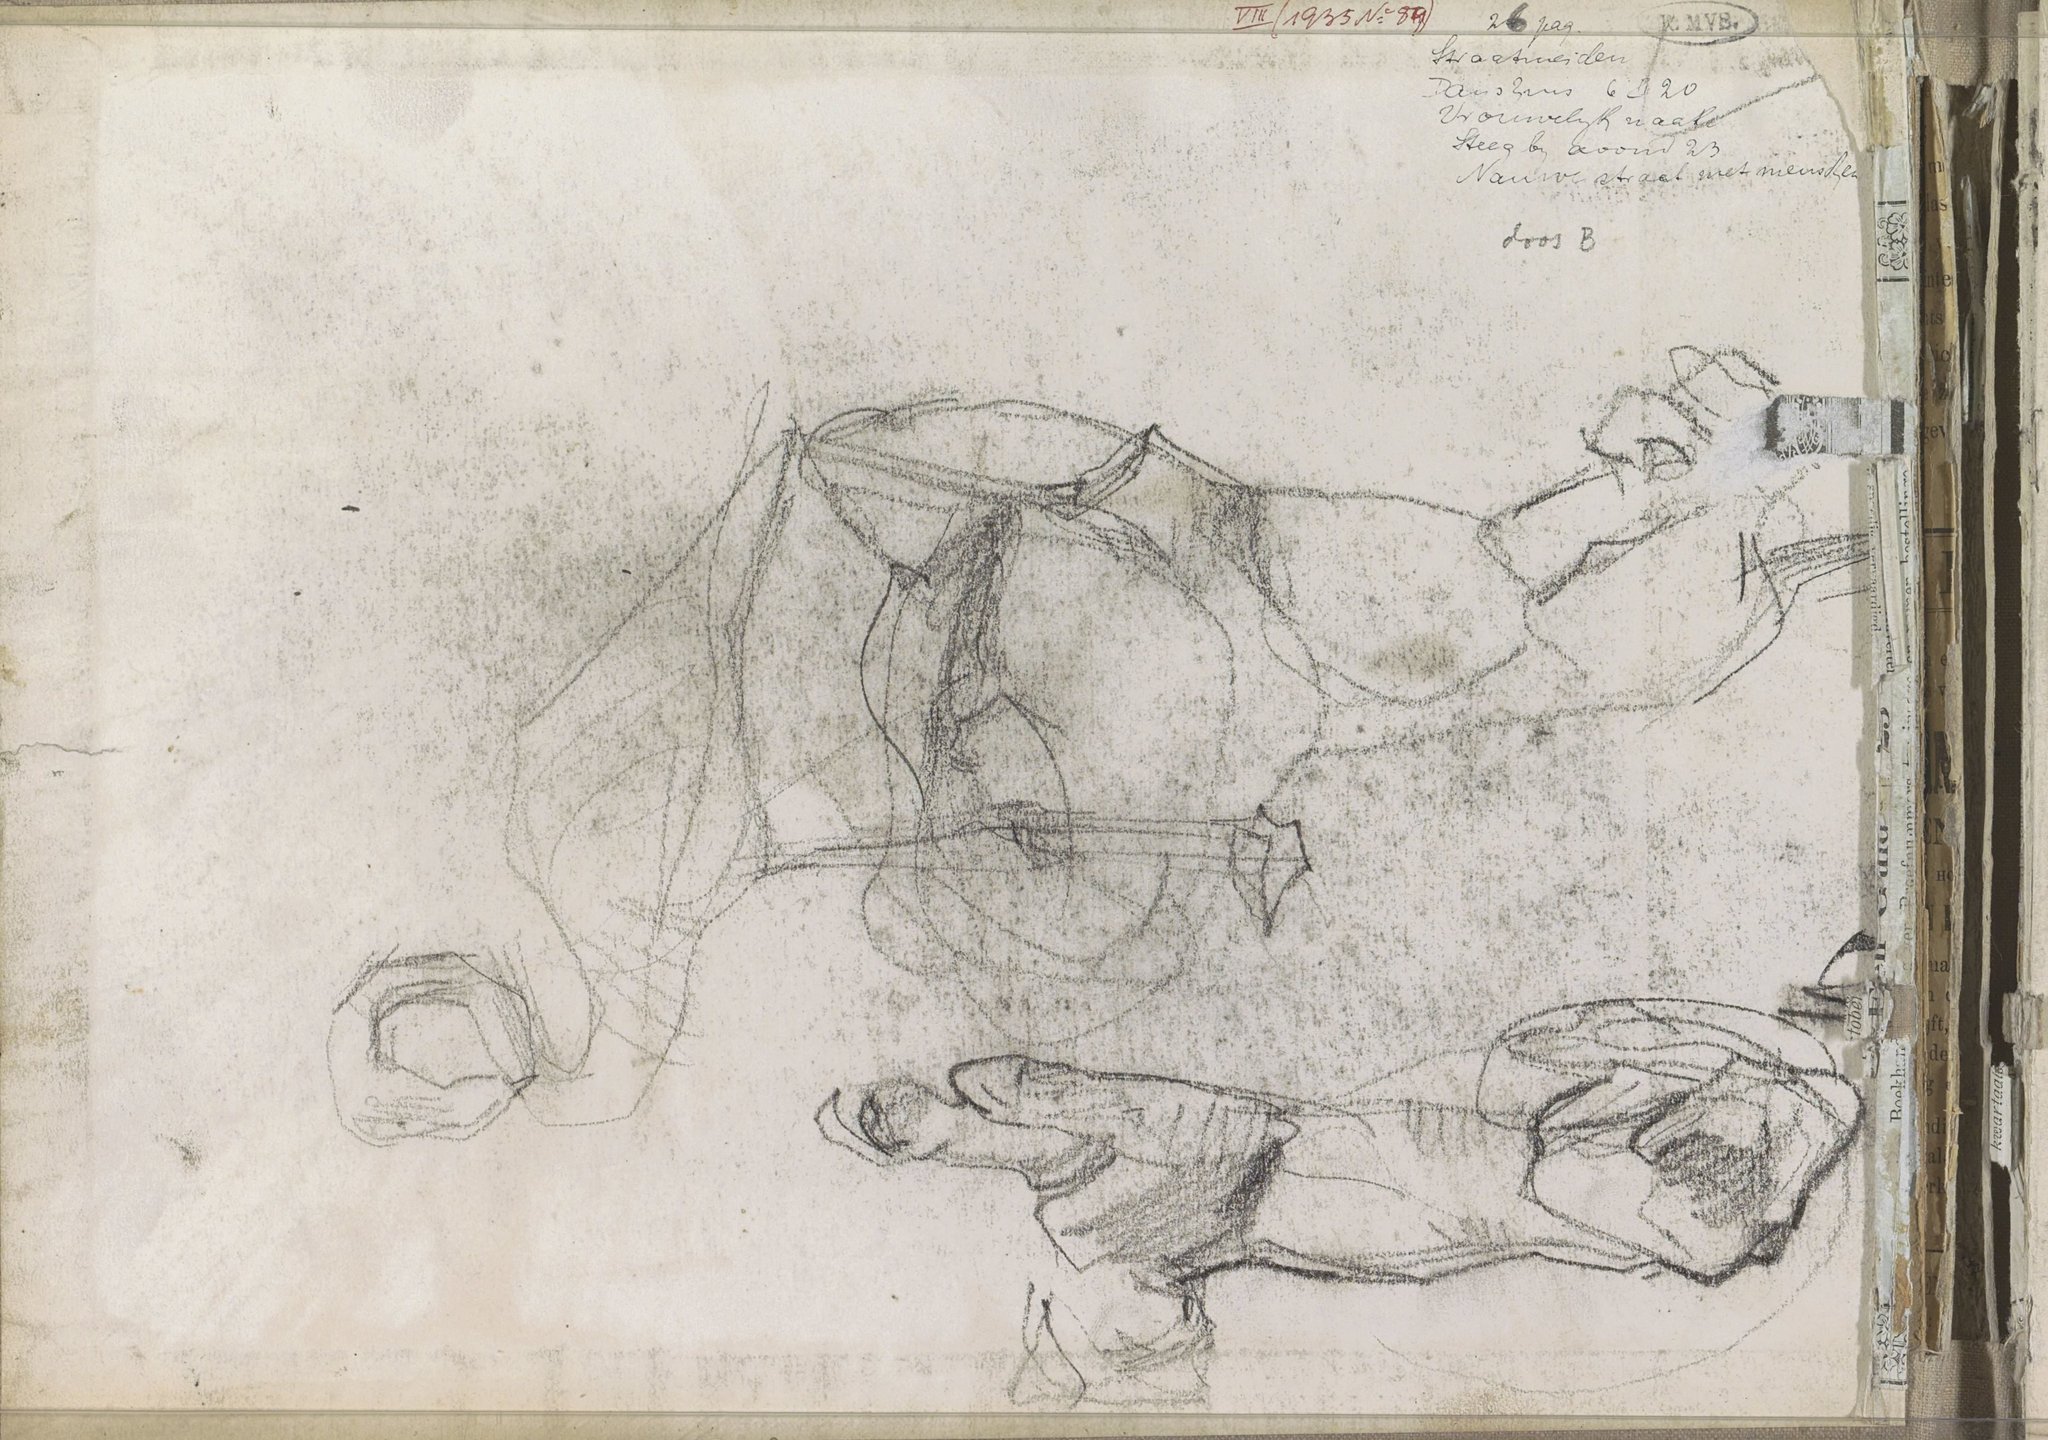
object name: sketchbook leaf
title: Leeuw, flamingo en mogelijk een leeuwin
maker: isaac israels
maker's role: draughtsman, painter, print maker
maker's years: 1865-1934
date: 1892-1900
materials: chalk, paper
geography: the hague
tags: birds, beasts of prey, predatory animals: lion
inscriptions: collector's mark: Lugt 2228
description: Schutblad A, voorste schutblad, uit schetsboek VIII met 12 bladen.